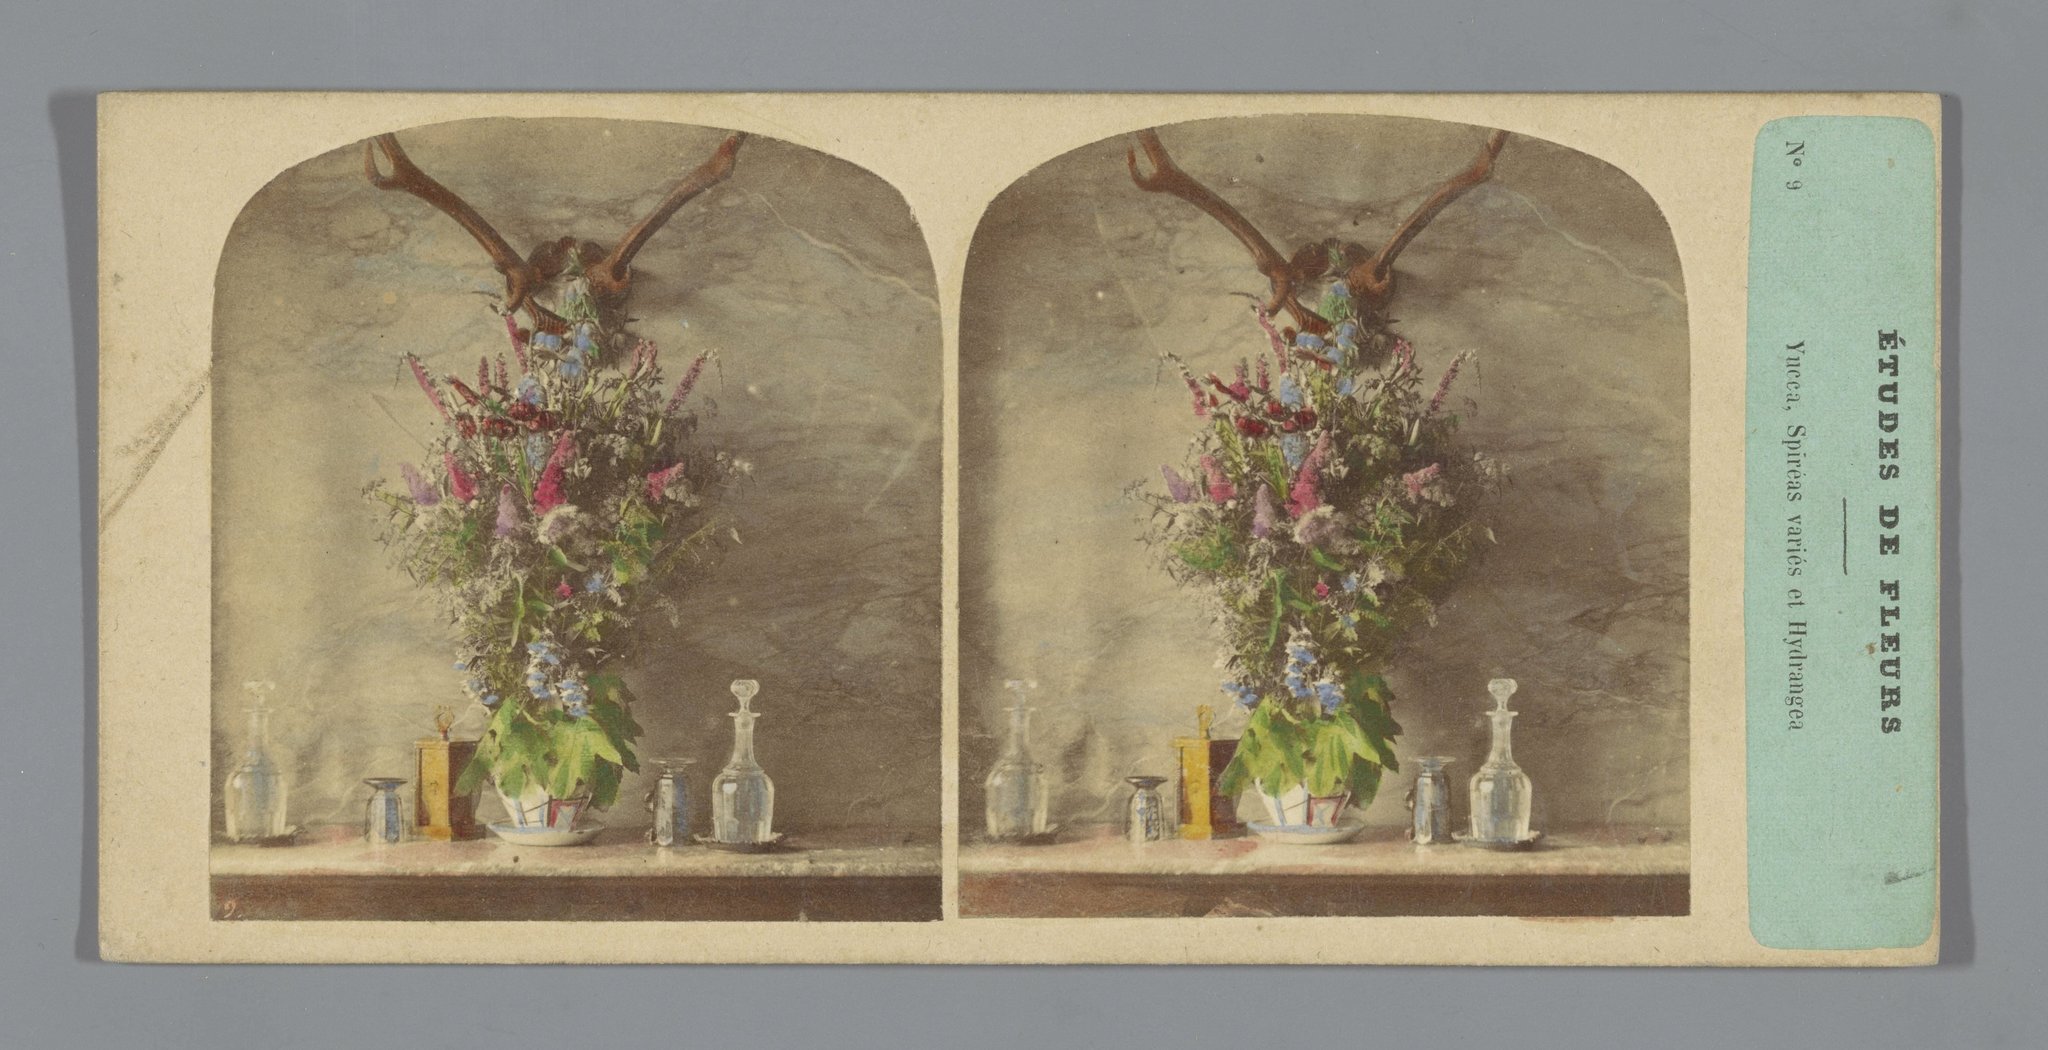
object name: stereograph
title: Yucca, spiréas variés et hydrangea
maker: Anonymous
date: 1852-1863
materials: cardboard, paper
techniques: albumen print, hand coloring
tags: flowers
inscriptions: retailer's mark: ‘Feldbrugge & Co./ Groningen’, number: ‘9’, inscription: ‘no 90’